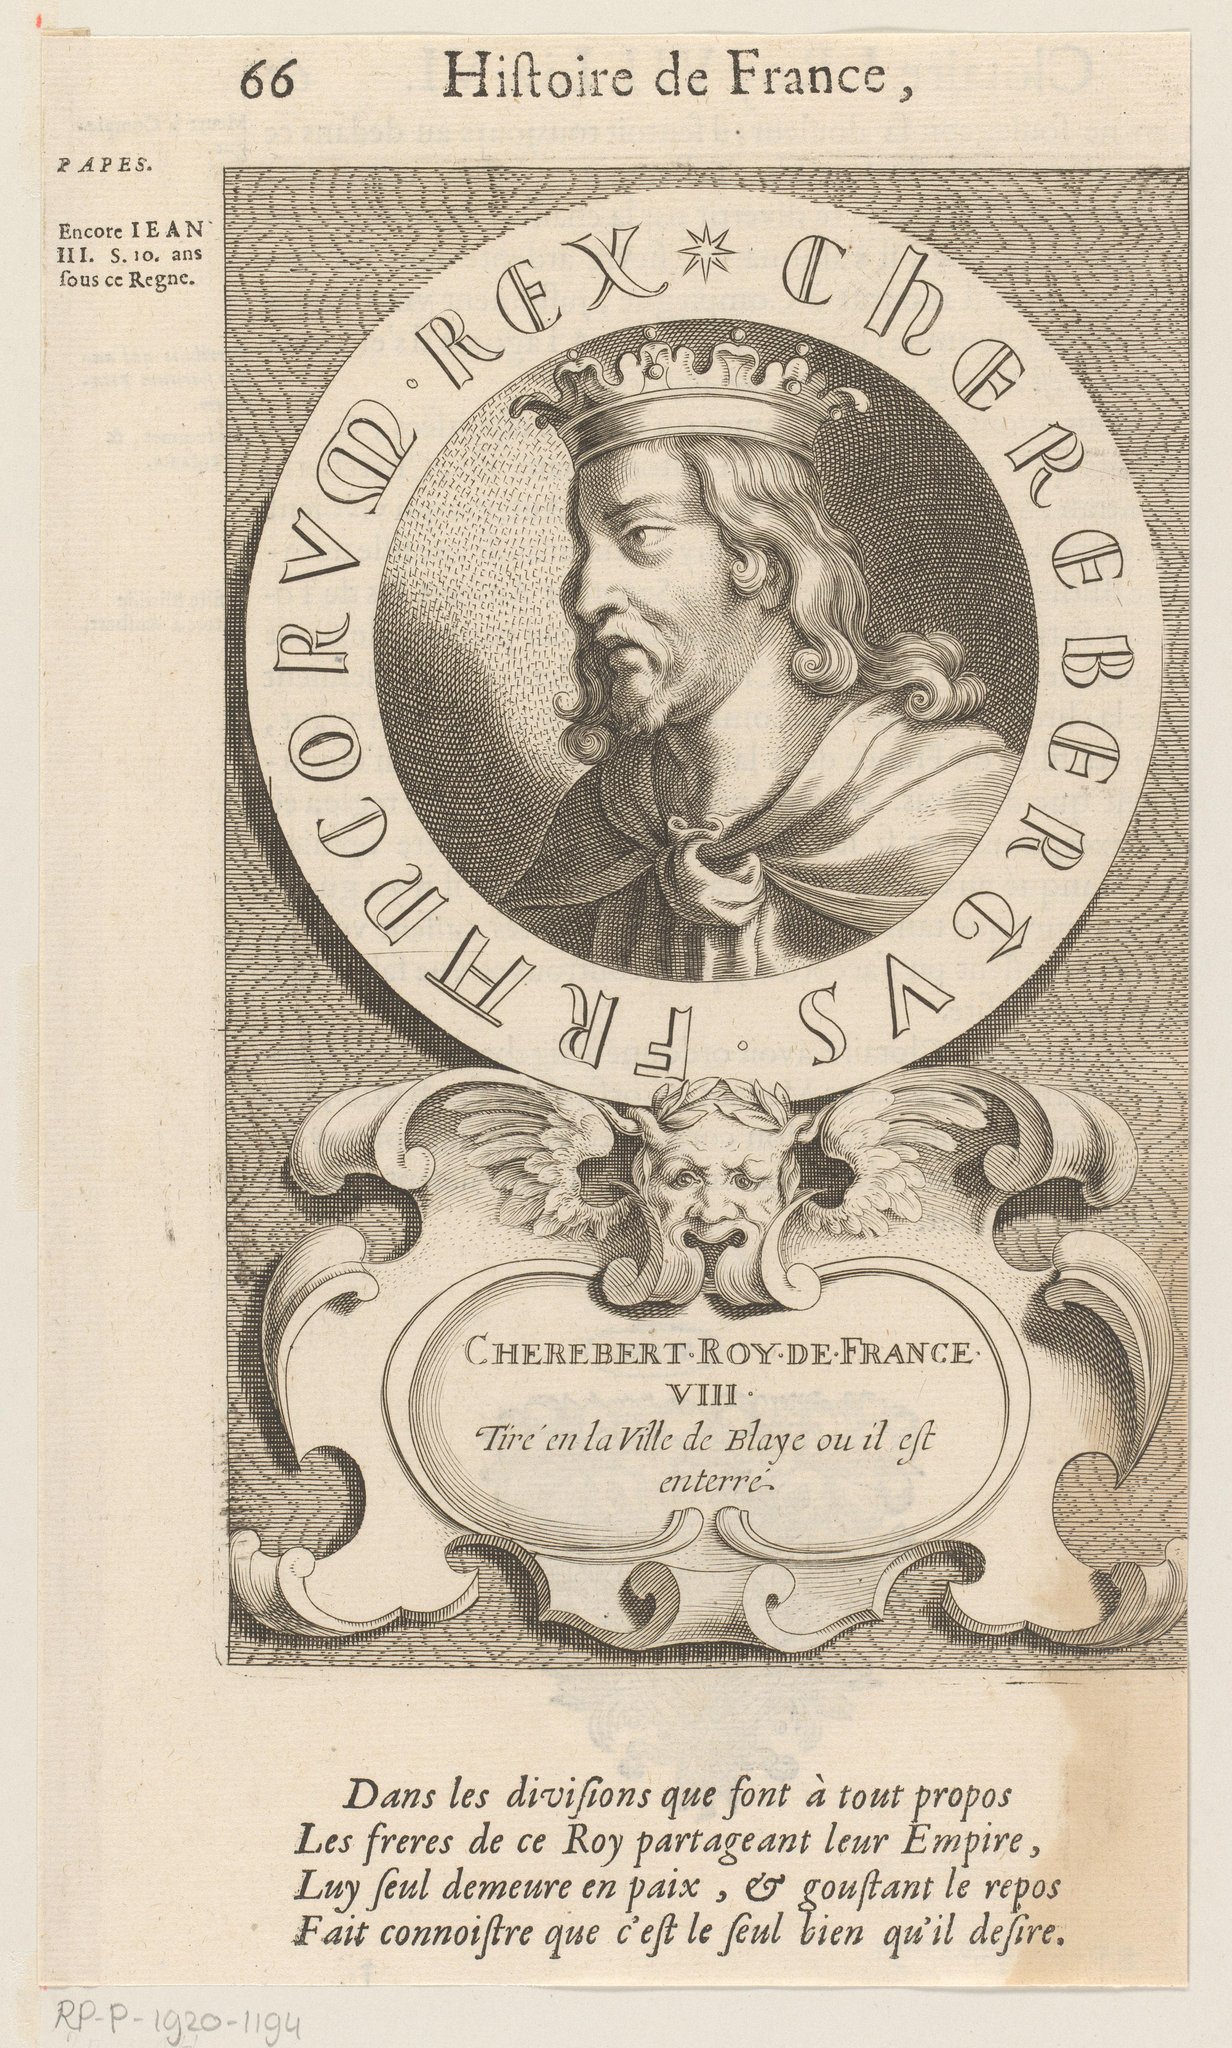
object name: print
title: Cherebert roy de France VIII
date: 1635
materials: paper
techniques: engraving, letterpress printing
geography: paris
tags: historical persons, ruler, sovereign, king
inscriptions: collector's mark: Lugt 2228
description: Prent uit: Eudes de Mézeray, François. Histoire de France, depuis Faramond jusqu’au regne de Louis le Juste (...). 3 dln. Parijs: Denis Thierry, Jean Guignard en Claude Barbin, 1635, dl. 1. Prent waarschijnlijk voor het eerst verschenen in: Bie, Jacques de. Les vrais portraits des rois de France (...). Parijs: Jacques de Bie en Pierre Rocolet, 1634. Prent ook gebruikt in latere publicaties.